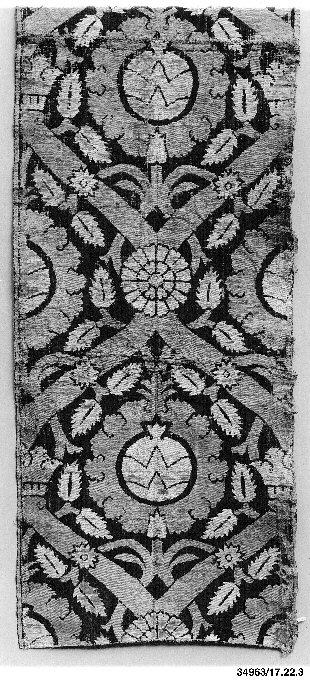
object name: fragment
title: Textile Fragment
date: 1567-1600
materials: metal thread, textile, velvet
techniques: brocade, cutting, voiding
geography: turkey